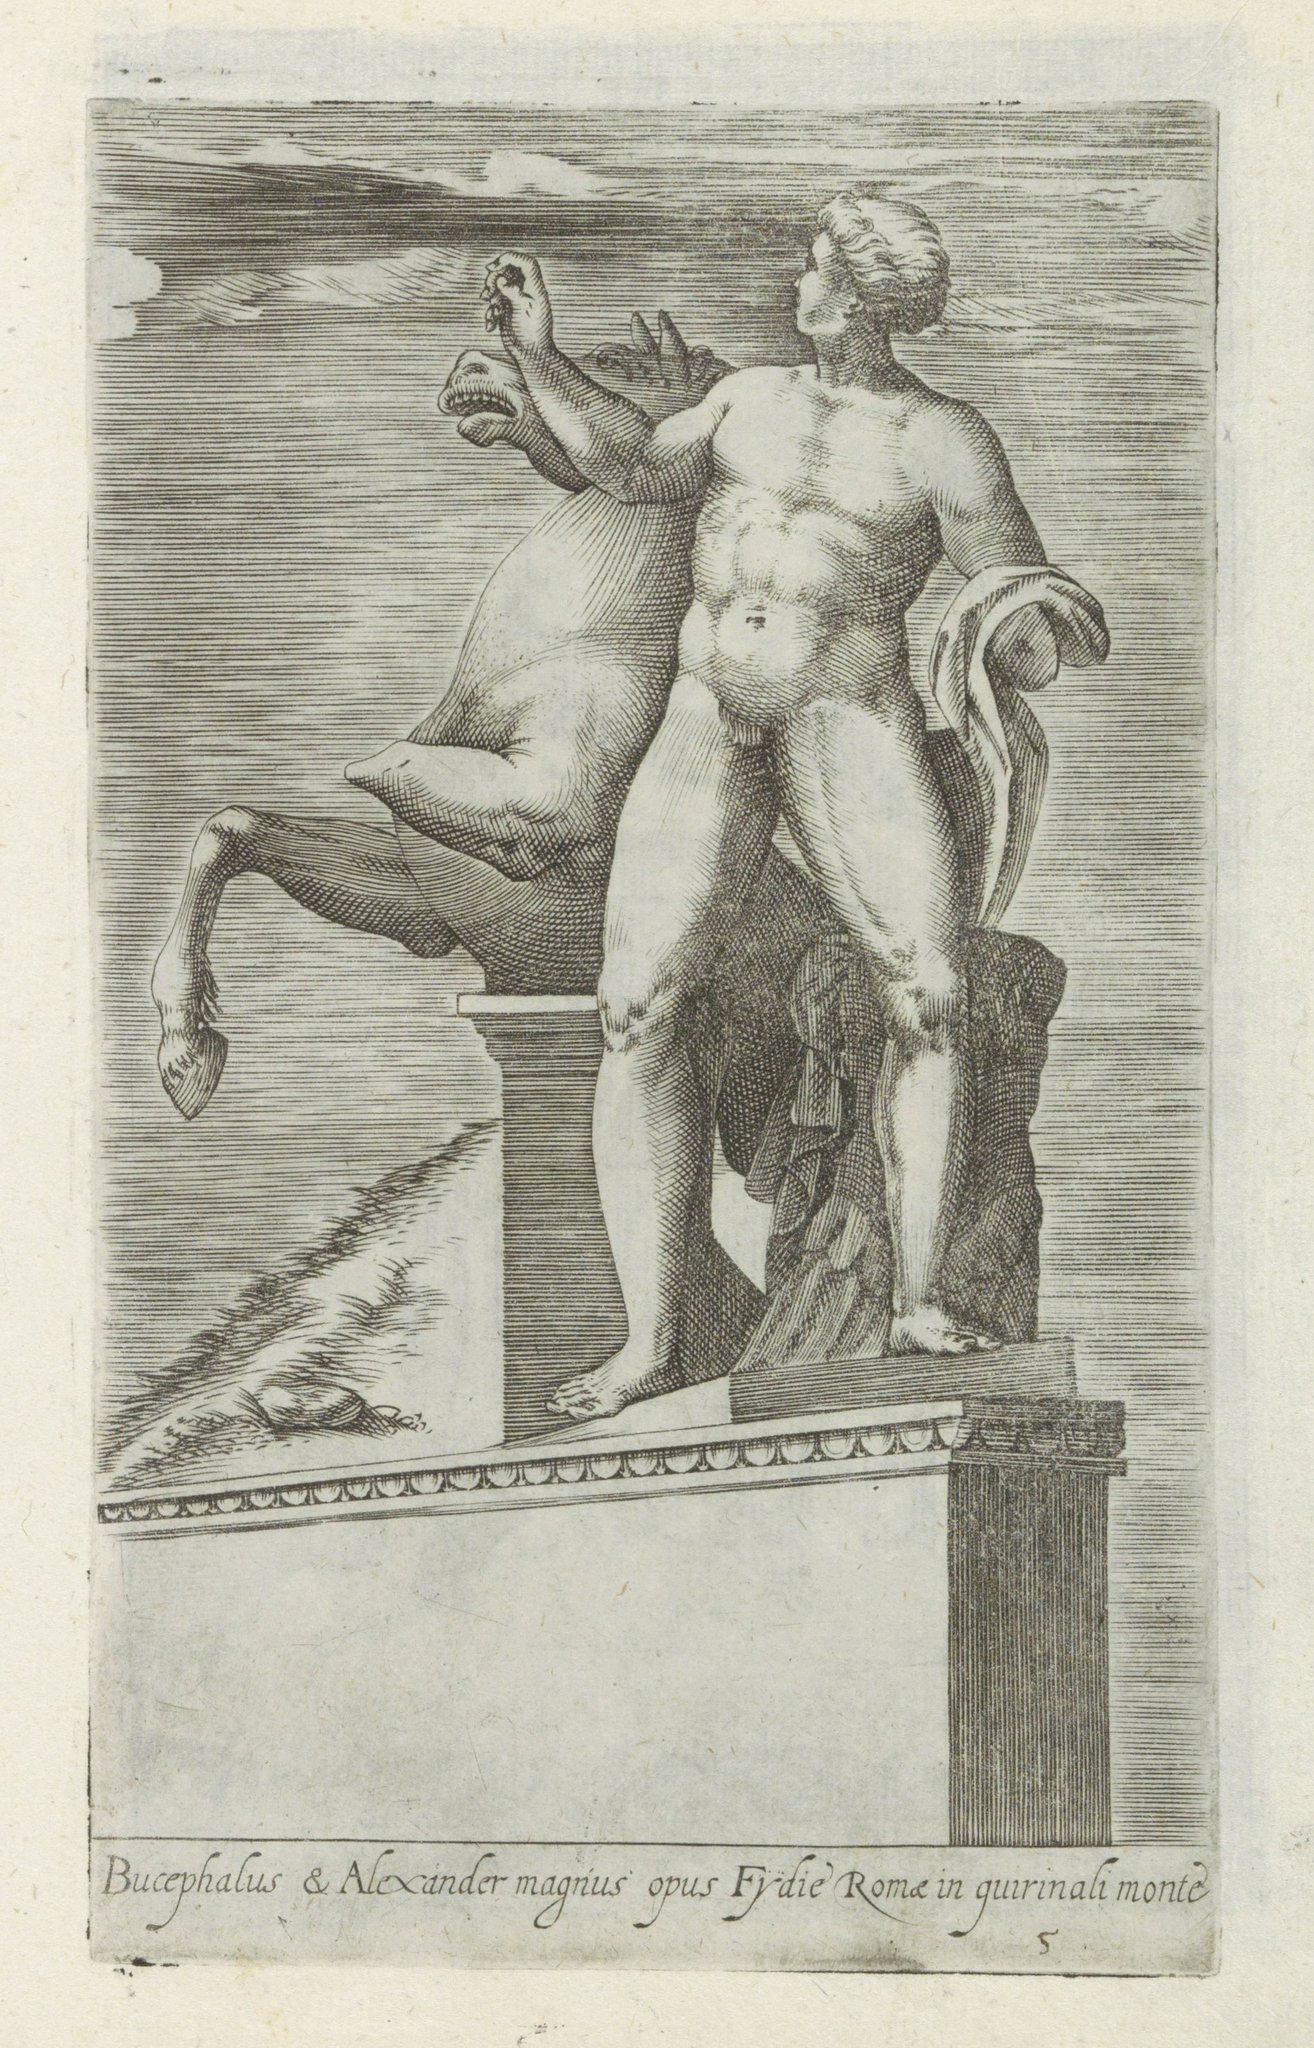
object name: album leaf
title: Bucephalus & Alexander magnus opus (...)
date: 1584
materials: paper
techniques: engraving, intaglio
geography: italy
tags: piece of sculpture, reproduction of a piece of sculpture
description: Een van de twee standbeelden van de Dioscuren (Castor en Pollux), twee naakte mannen met paarden. Voorheen geïnterpreteerd als de kunstenaars Pheidias en Praxiteles. De beelden staan op het Piazza del Quirinale in Rome. Onderschrift in het Latijn. Prent maakt deel uit van een album.